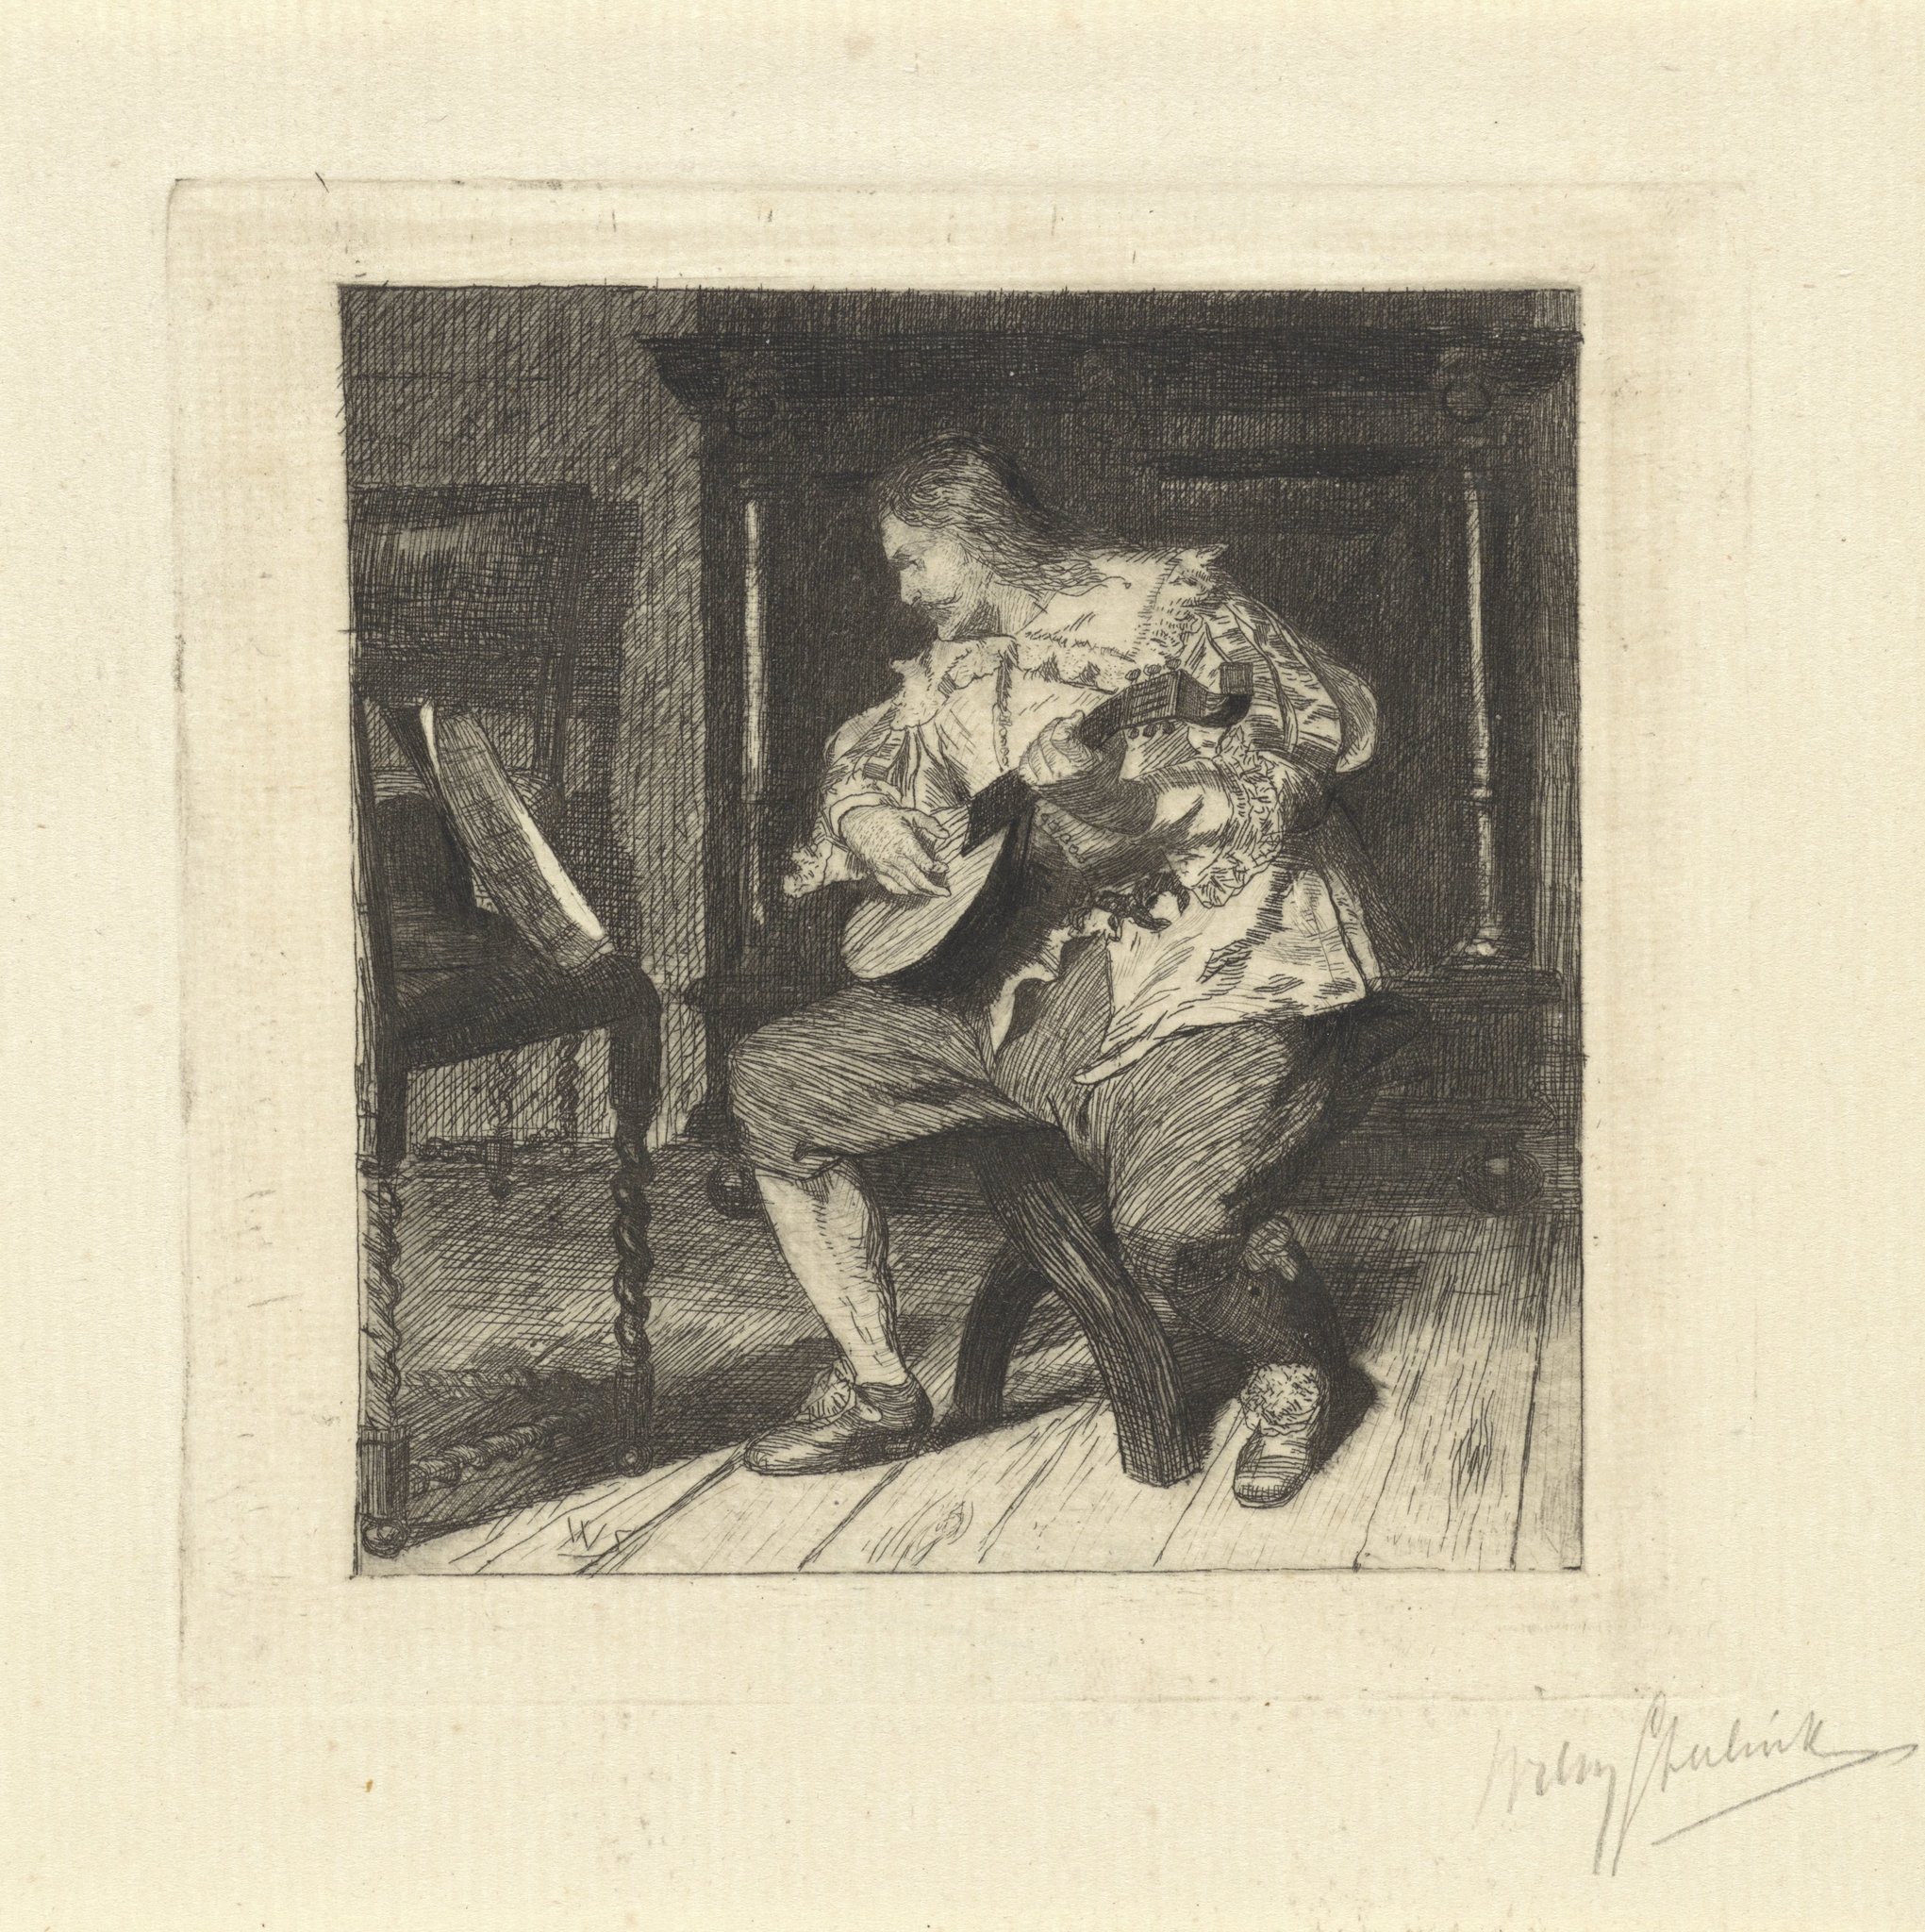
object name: print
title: Luitspeler spelend van bladmuziek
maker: willem steelink (ii)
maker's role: draughtsman, print maker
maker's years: 1856-1928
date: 1866-1928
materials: paper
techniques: etching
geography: netherlands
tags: lute, and special forms of lute, e.g.: theorbo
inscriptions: collector's mark: Lugt 2228